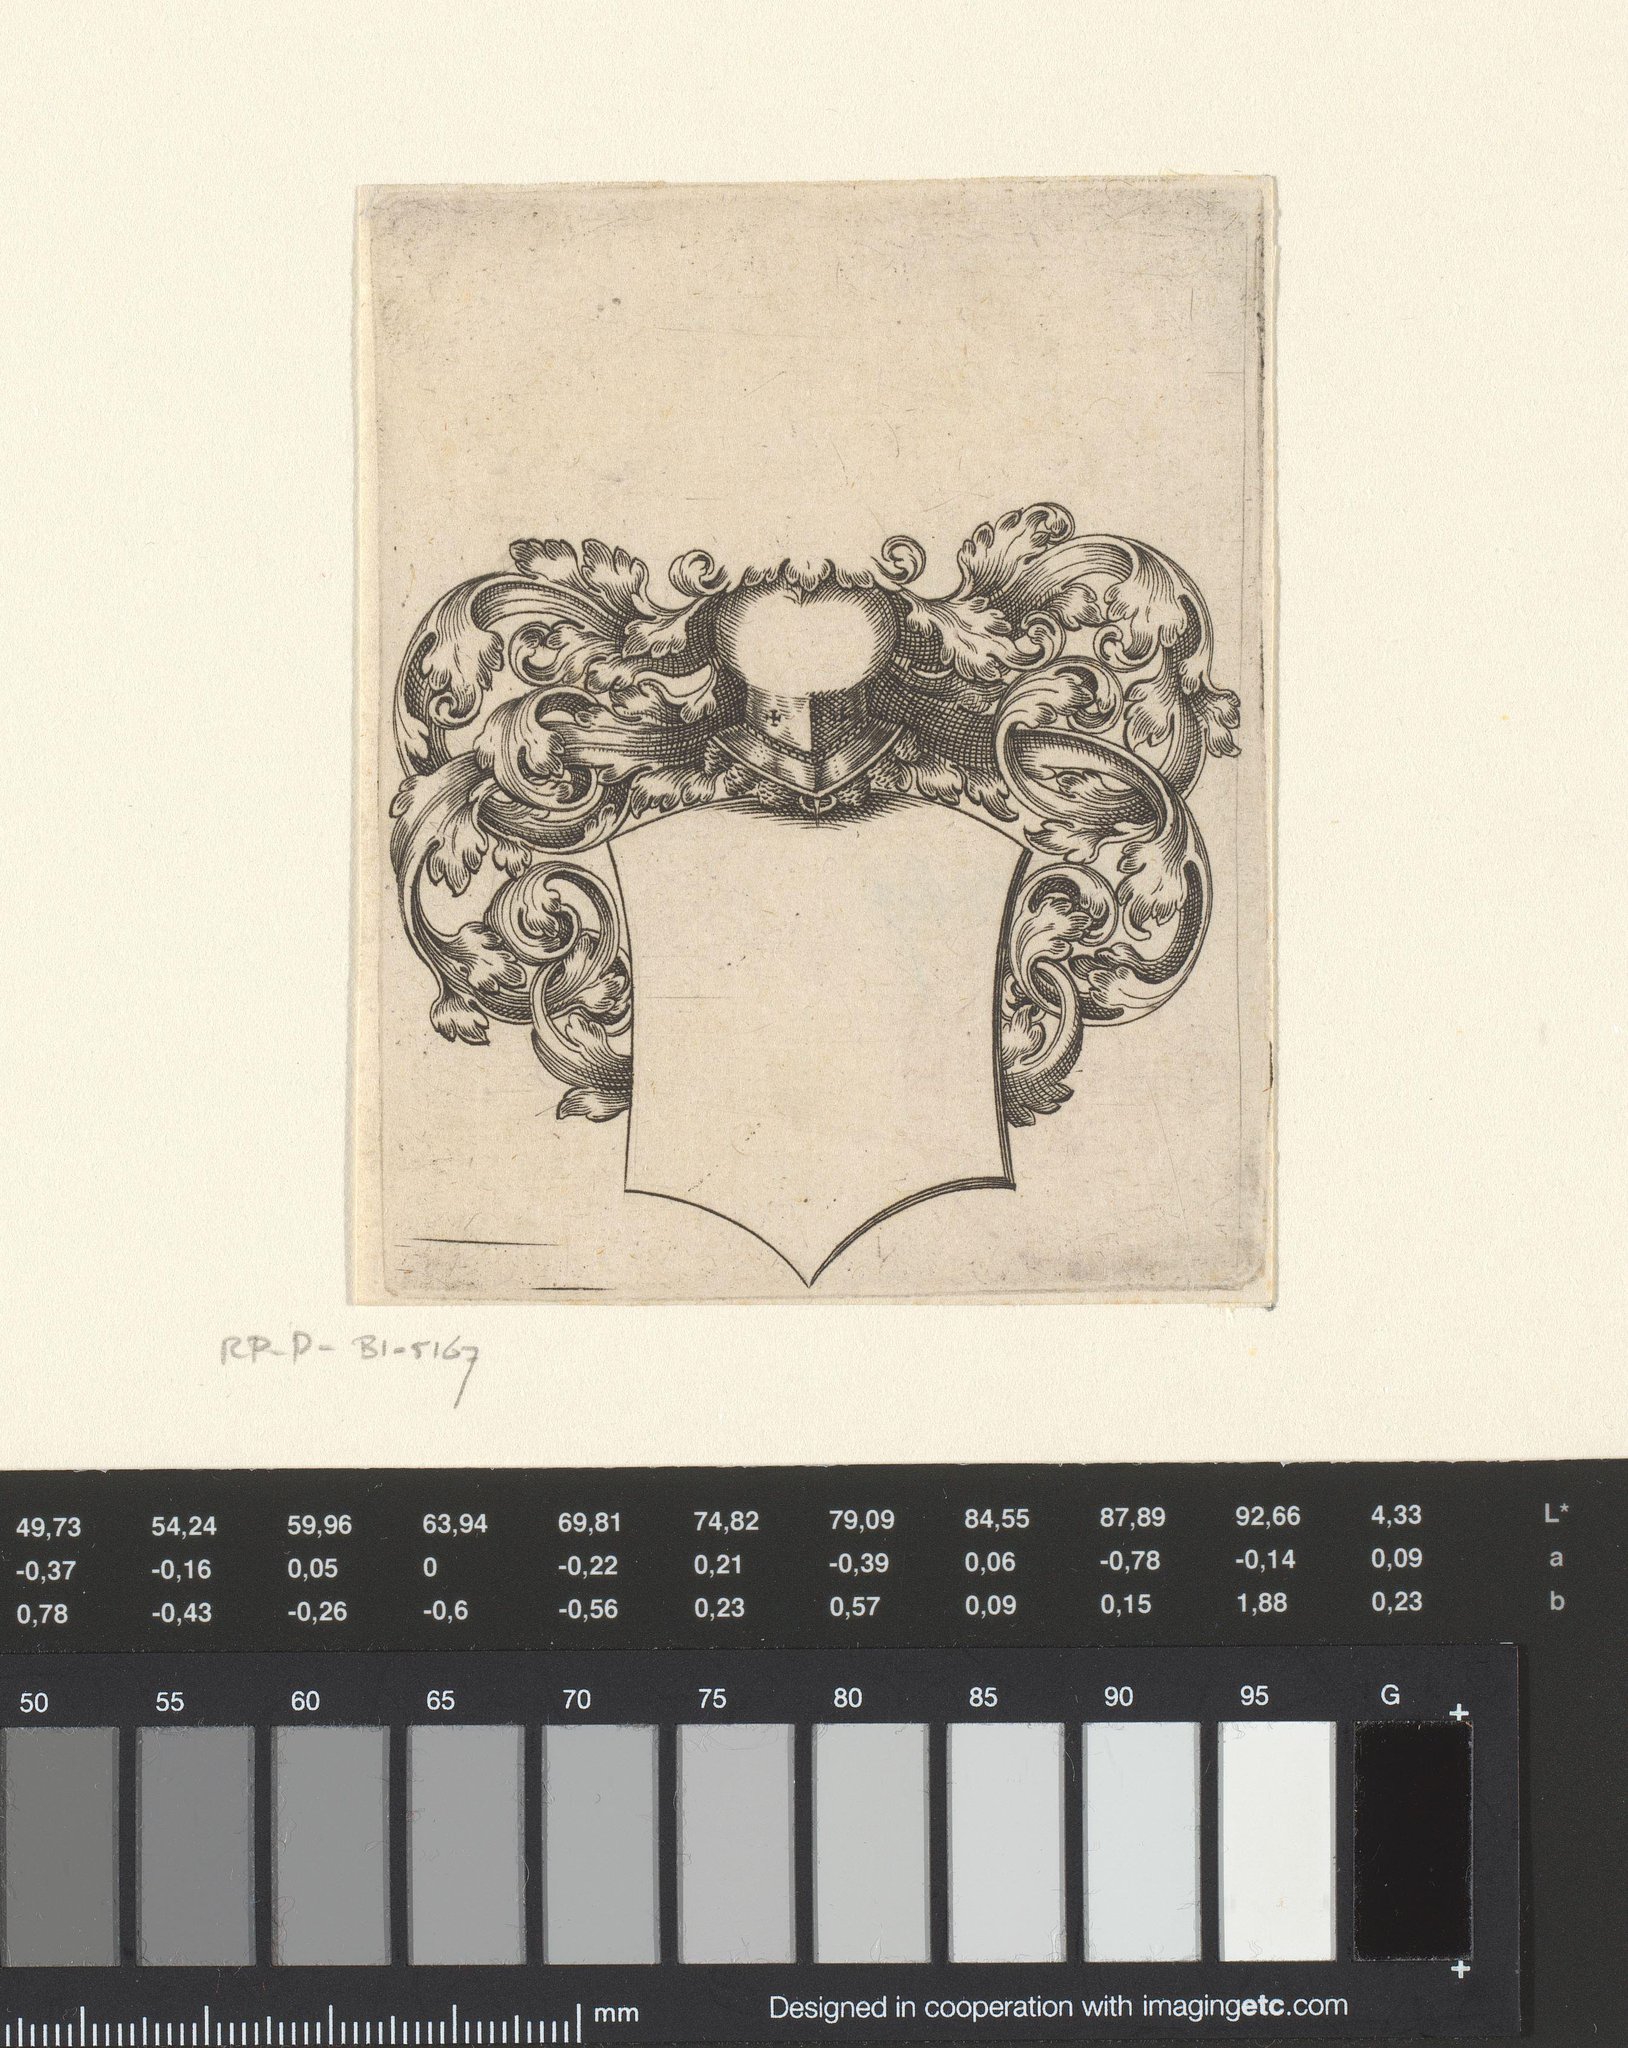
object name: print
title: Wapensjabloon met helm en bladranken, schild staat op een punt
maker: johann theodor de bry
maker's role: print maker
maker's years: 1561-1623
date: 1596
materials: paper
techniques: engraving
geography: frankfurt am main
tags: armorial bearing, heraldry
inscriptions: collector's mark: Lugt 240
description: Afkomstig uit: Emblemata Saecularia. Mira et iucunda varietate seculi huius mores ita experimentia (...). 1e druk. Frankfurt am Main: J.T. de Bry en J.I. de Bry, 1596.